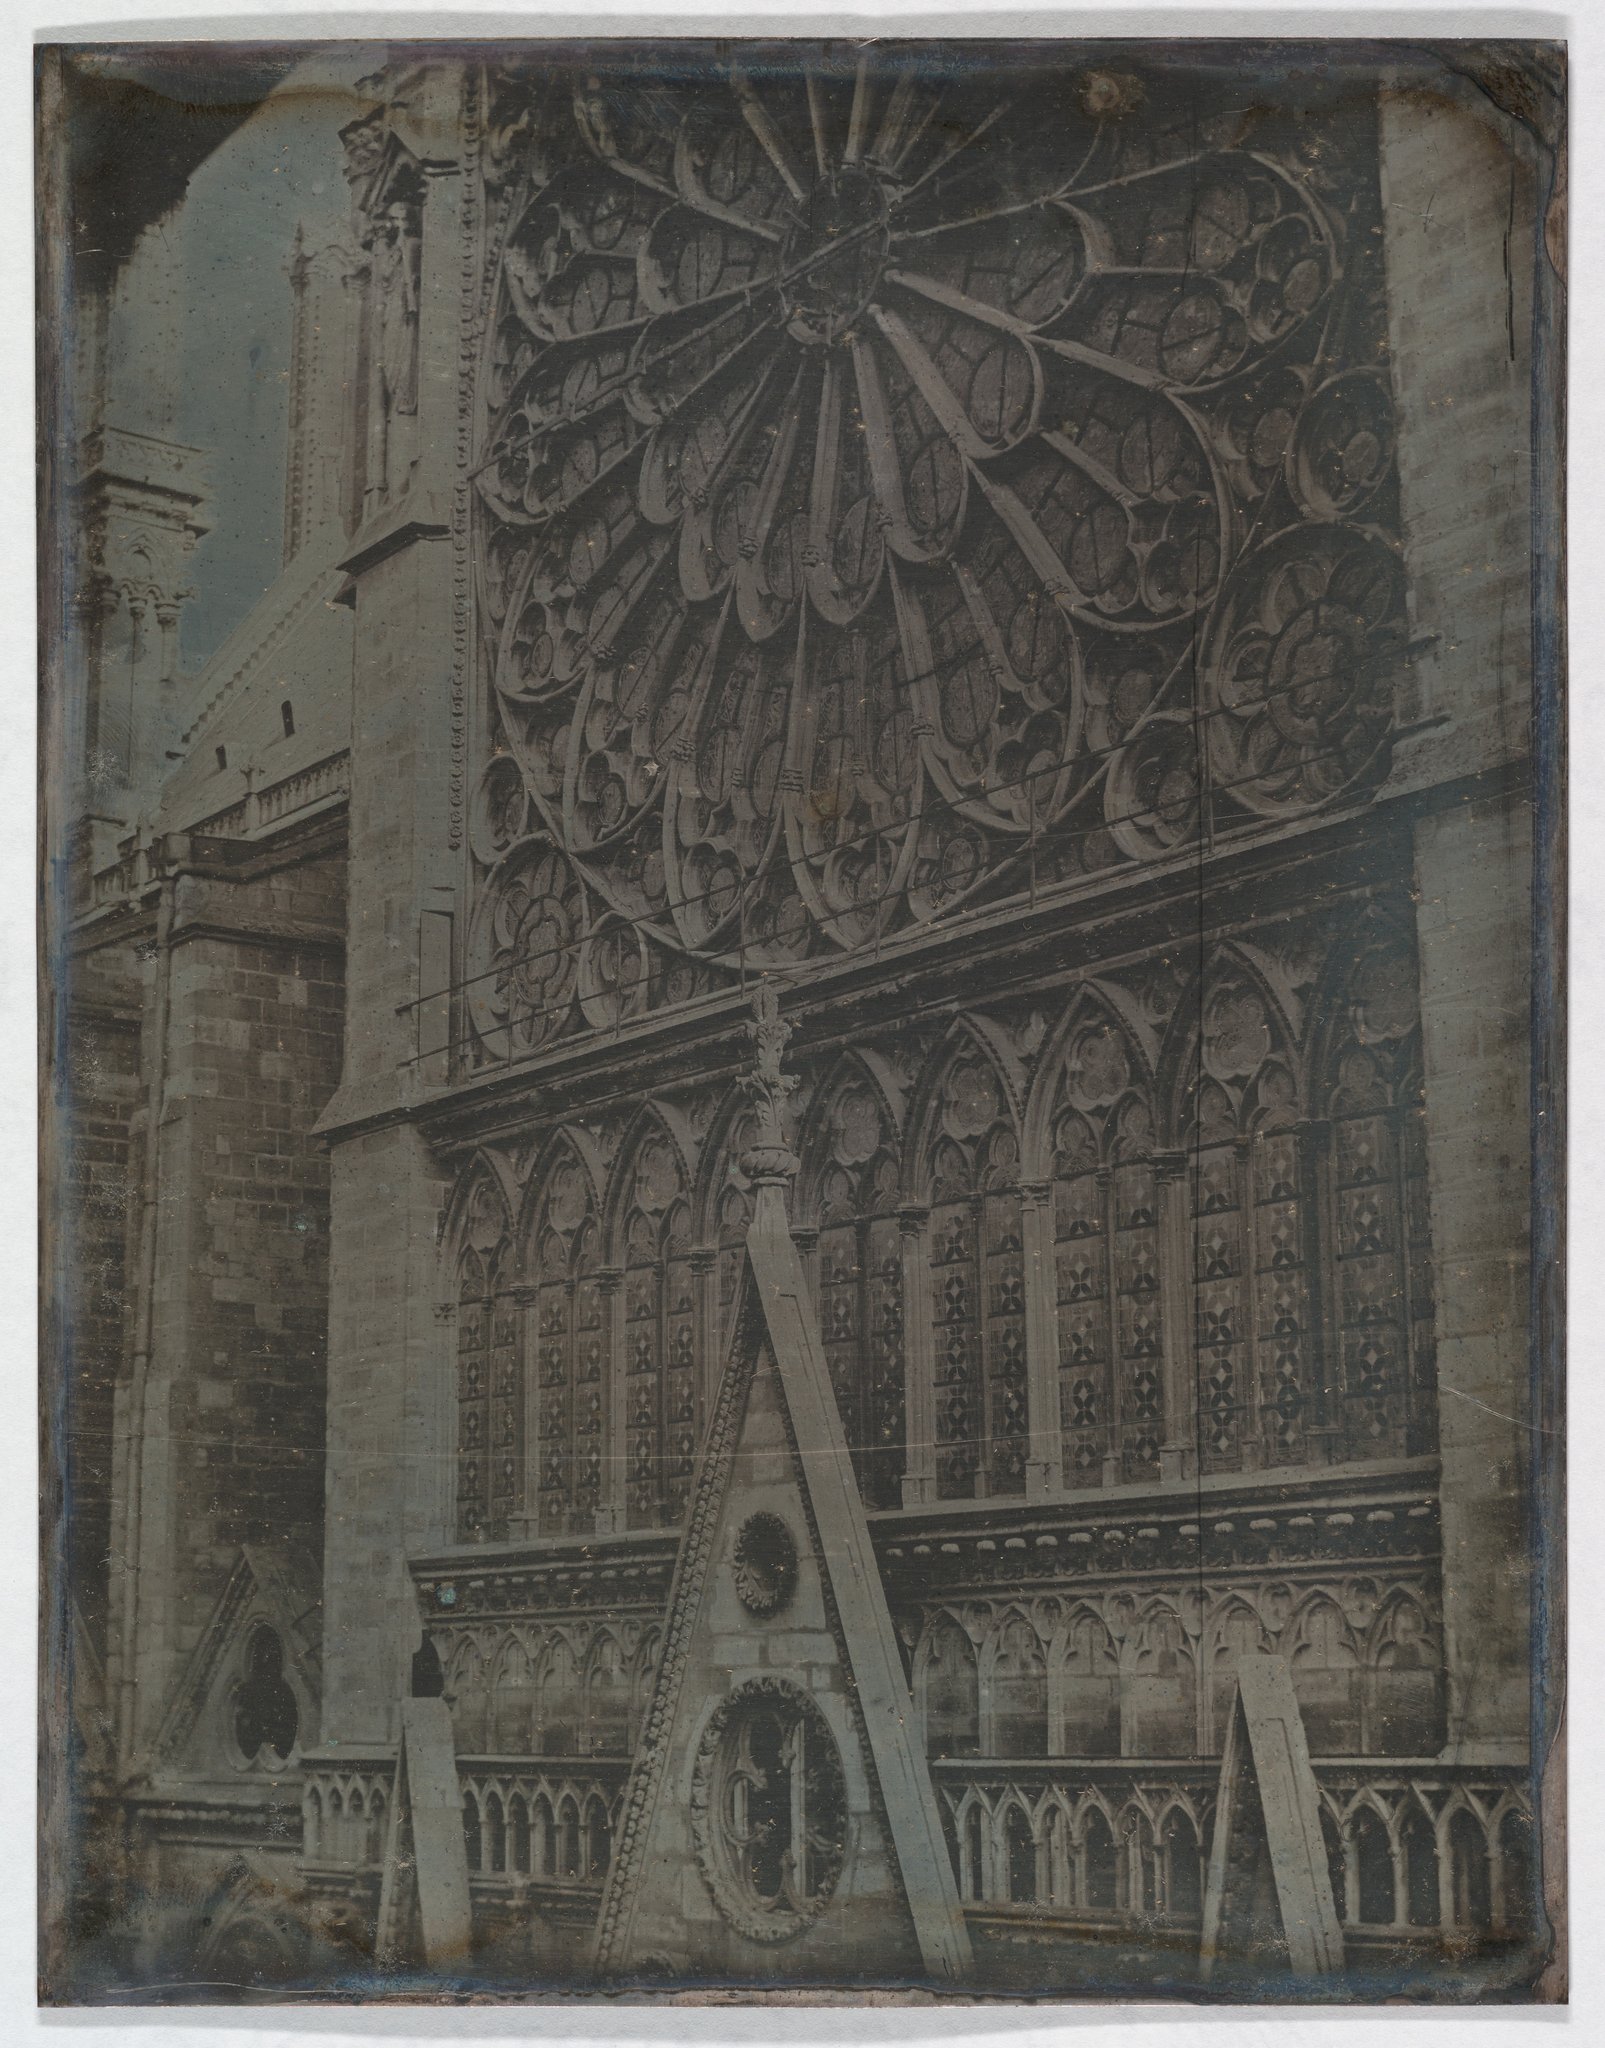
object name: photograph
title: Rose Window, Notre-Dame Cathedral, Paris (277. Troyes. 1841. Cathedrale. Gde. Rose. Fichot-Paris [sic])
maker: joseph-philibert girault de prangey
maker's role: artist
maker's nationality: french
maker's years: 1804-1892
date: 1841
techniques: daguerreotype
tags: architecture,windows,cathedrals,paris